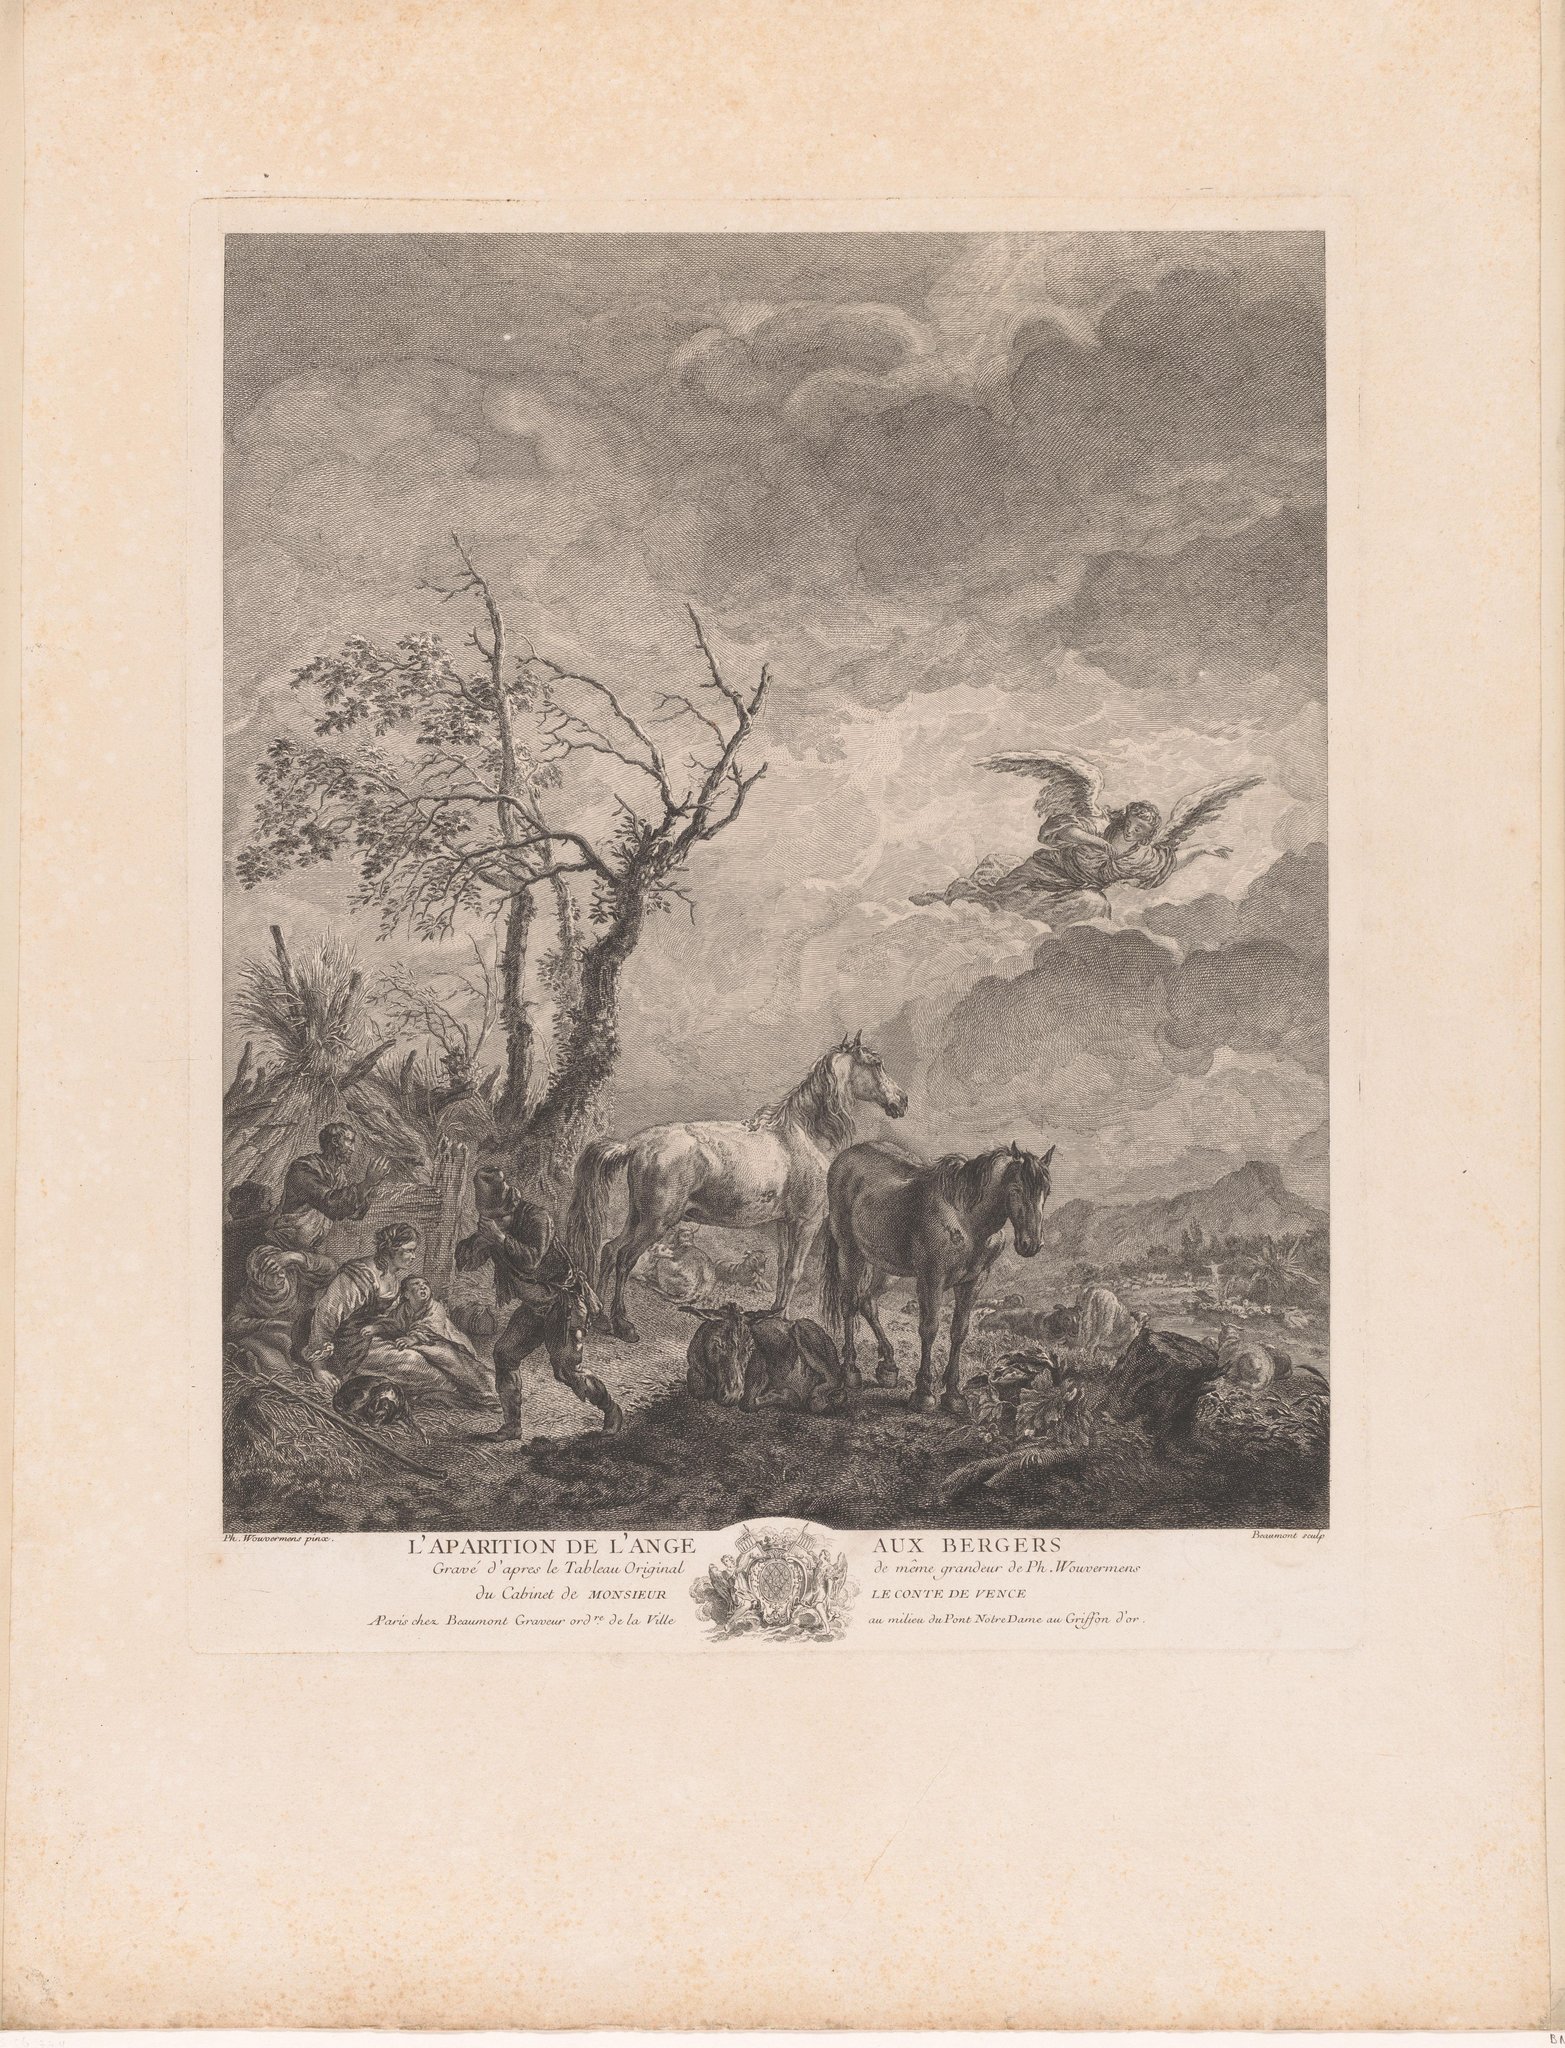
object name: print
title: L'Aparition de l'ange aux bergers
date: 1735-1740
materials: paper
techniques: engraving, etching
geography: paris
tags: annunciation of christ's birth to the shepherds (and/or shepherdesses) at night; a host of singing angels in the air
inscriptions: collector's mark: Lugt 240